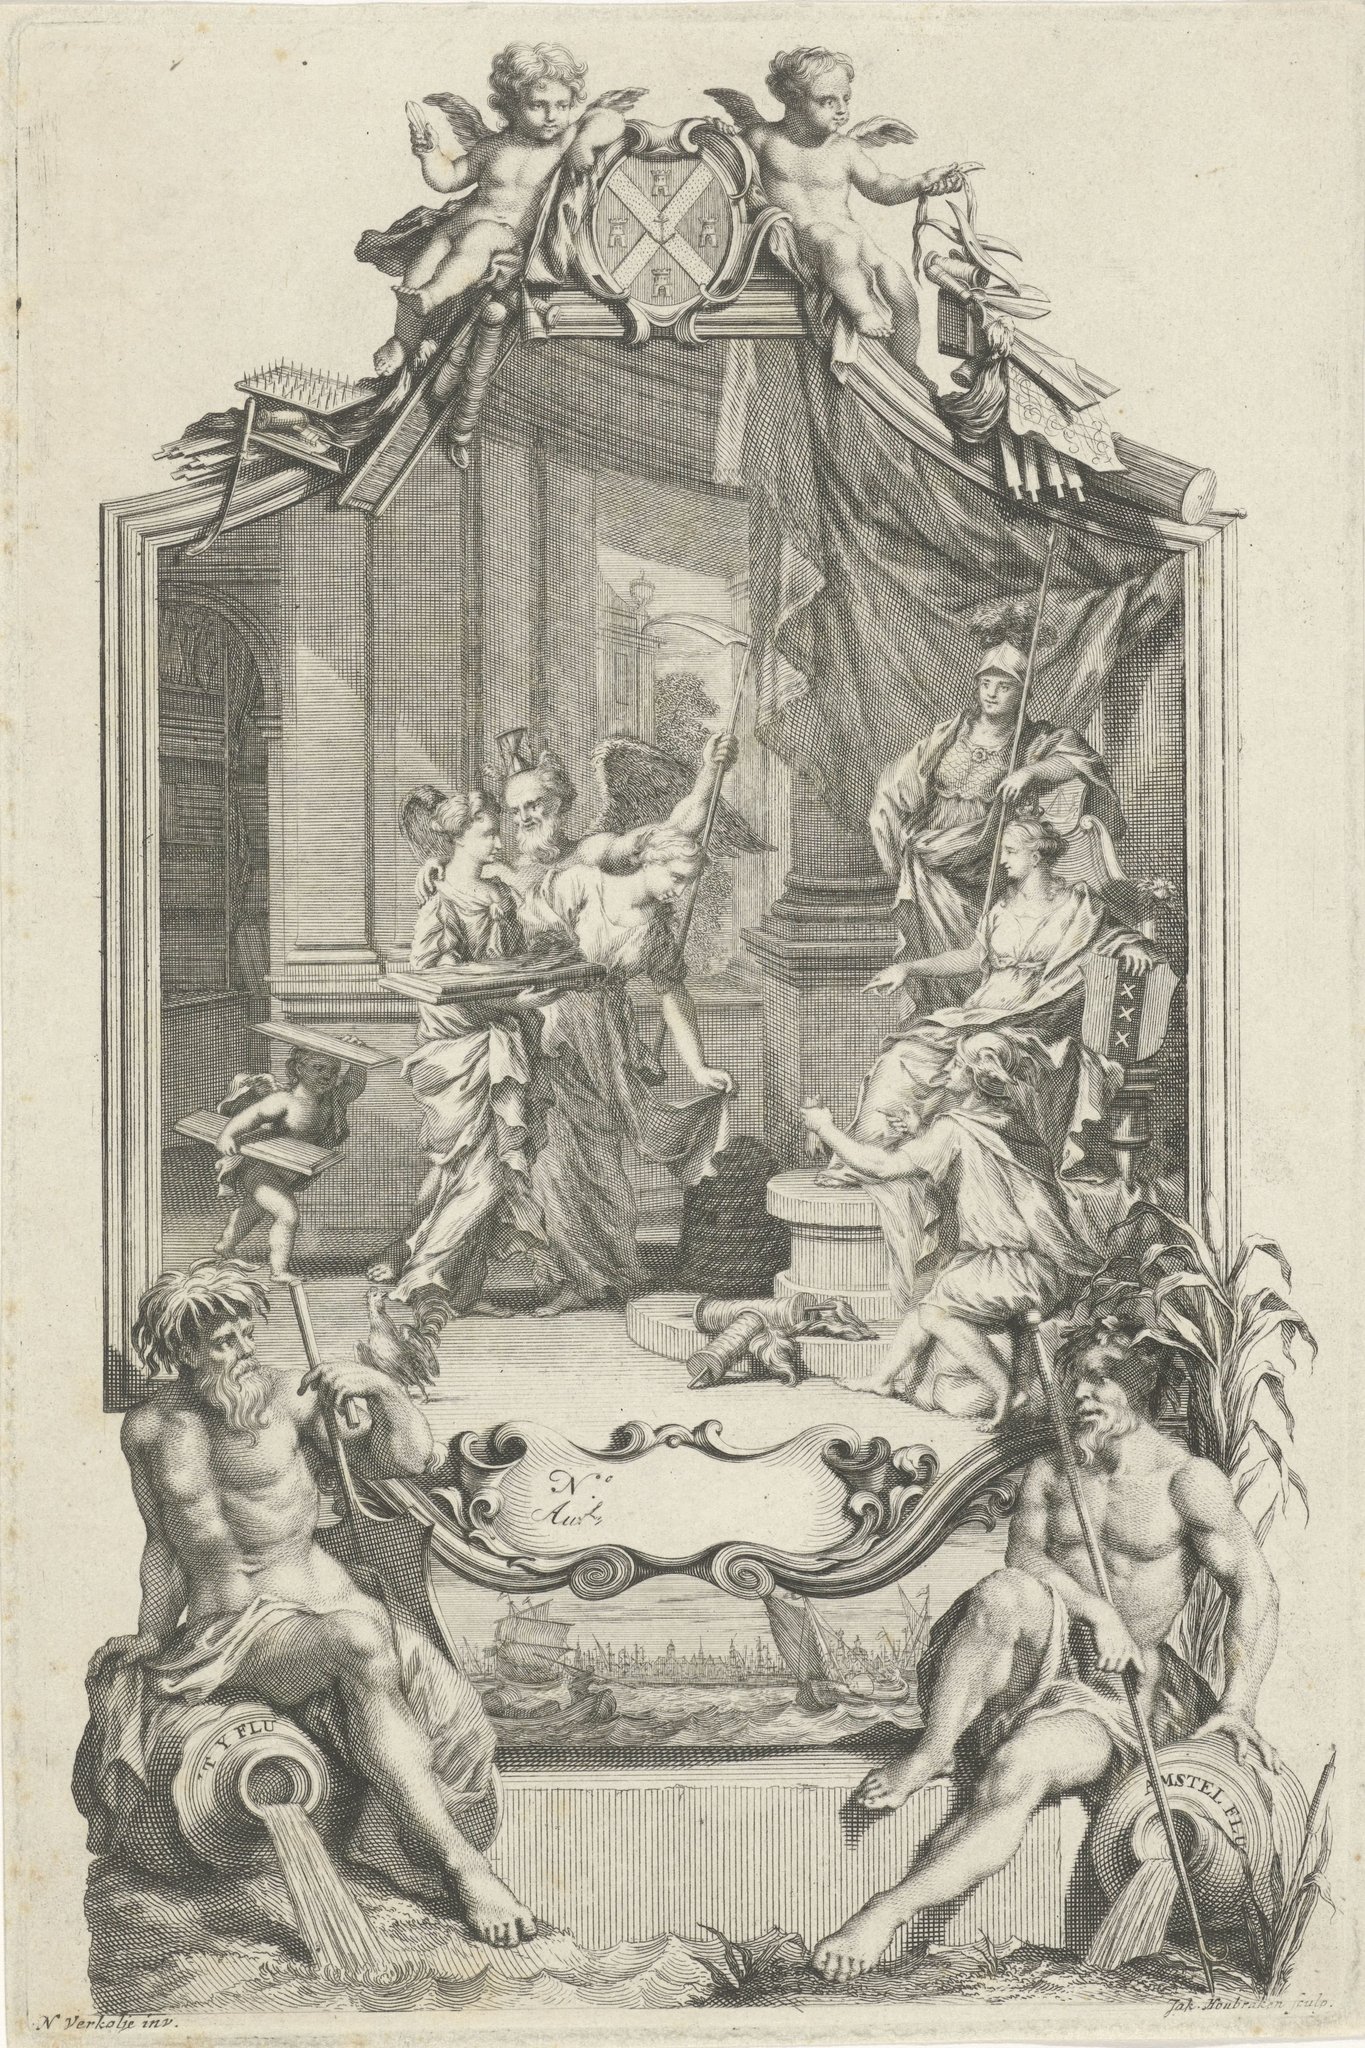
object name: print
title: Allegorie op de zijde-industrie in Amsterdam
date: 1720-1746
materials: paper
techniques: engraving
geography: amsterdam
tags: minerva as patroness, river personified, 'fiumi' (ripa), specific aspects, allegorical aspects of mercury; mercury as patron, armorial bearing, heraldry, silk (material ~ textile industry), amsterdam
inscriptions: collector's mark: Lugt 2760, collector's mark: Lugt 2228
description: Allegorie op de zijde-industrie in Amsterdam: de Stedenmaagd, geflankeerd door Wijsheid (Minerva) en Koophandel (Mercurius), ontvangt balen zijde. Onder de voorstelling de stroomgoden van Amstel en 't IJ met tussen hen in een profiel van de stad Amsterdam met schepen op de voorgrond. Bovenaan twee putti met het wapen van de familie De Neufville en attributen behorende bij de zijdeweverij, zoals haspels, klossen, scharen en een ontwerp voor een patroon voor een stof.